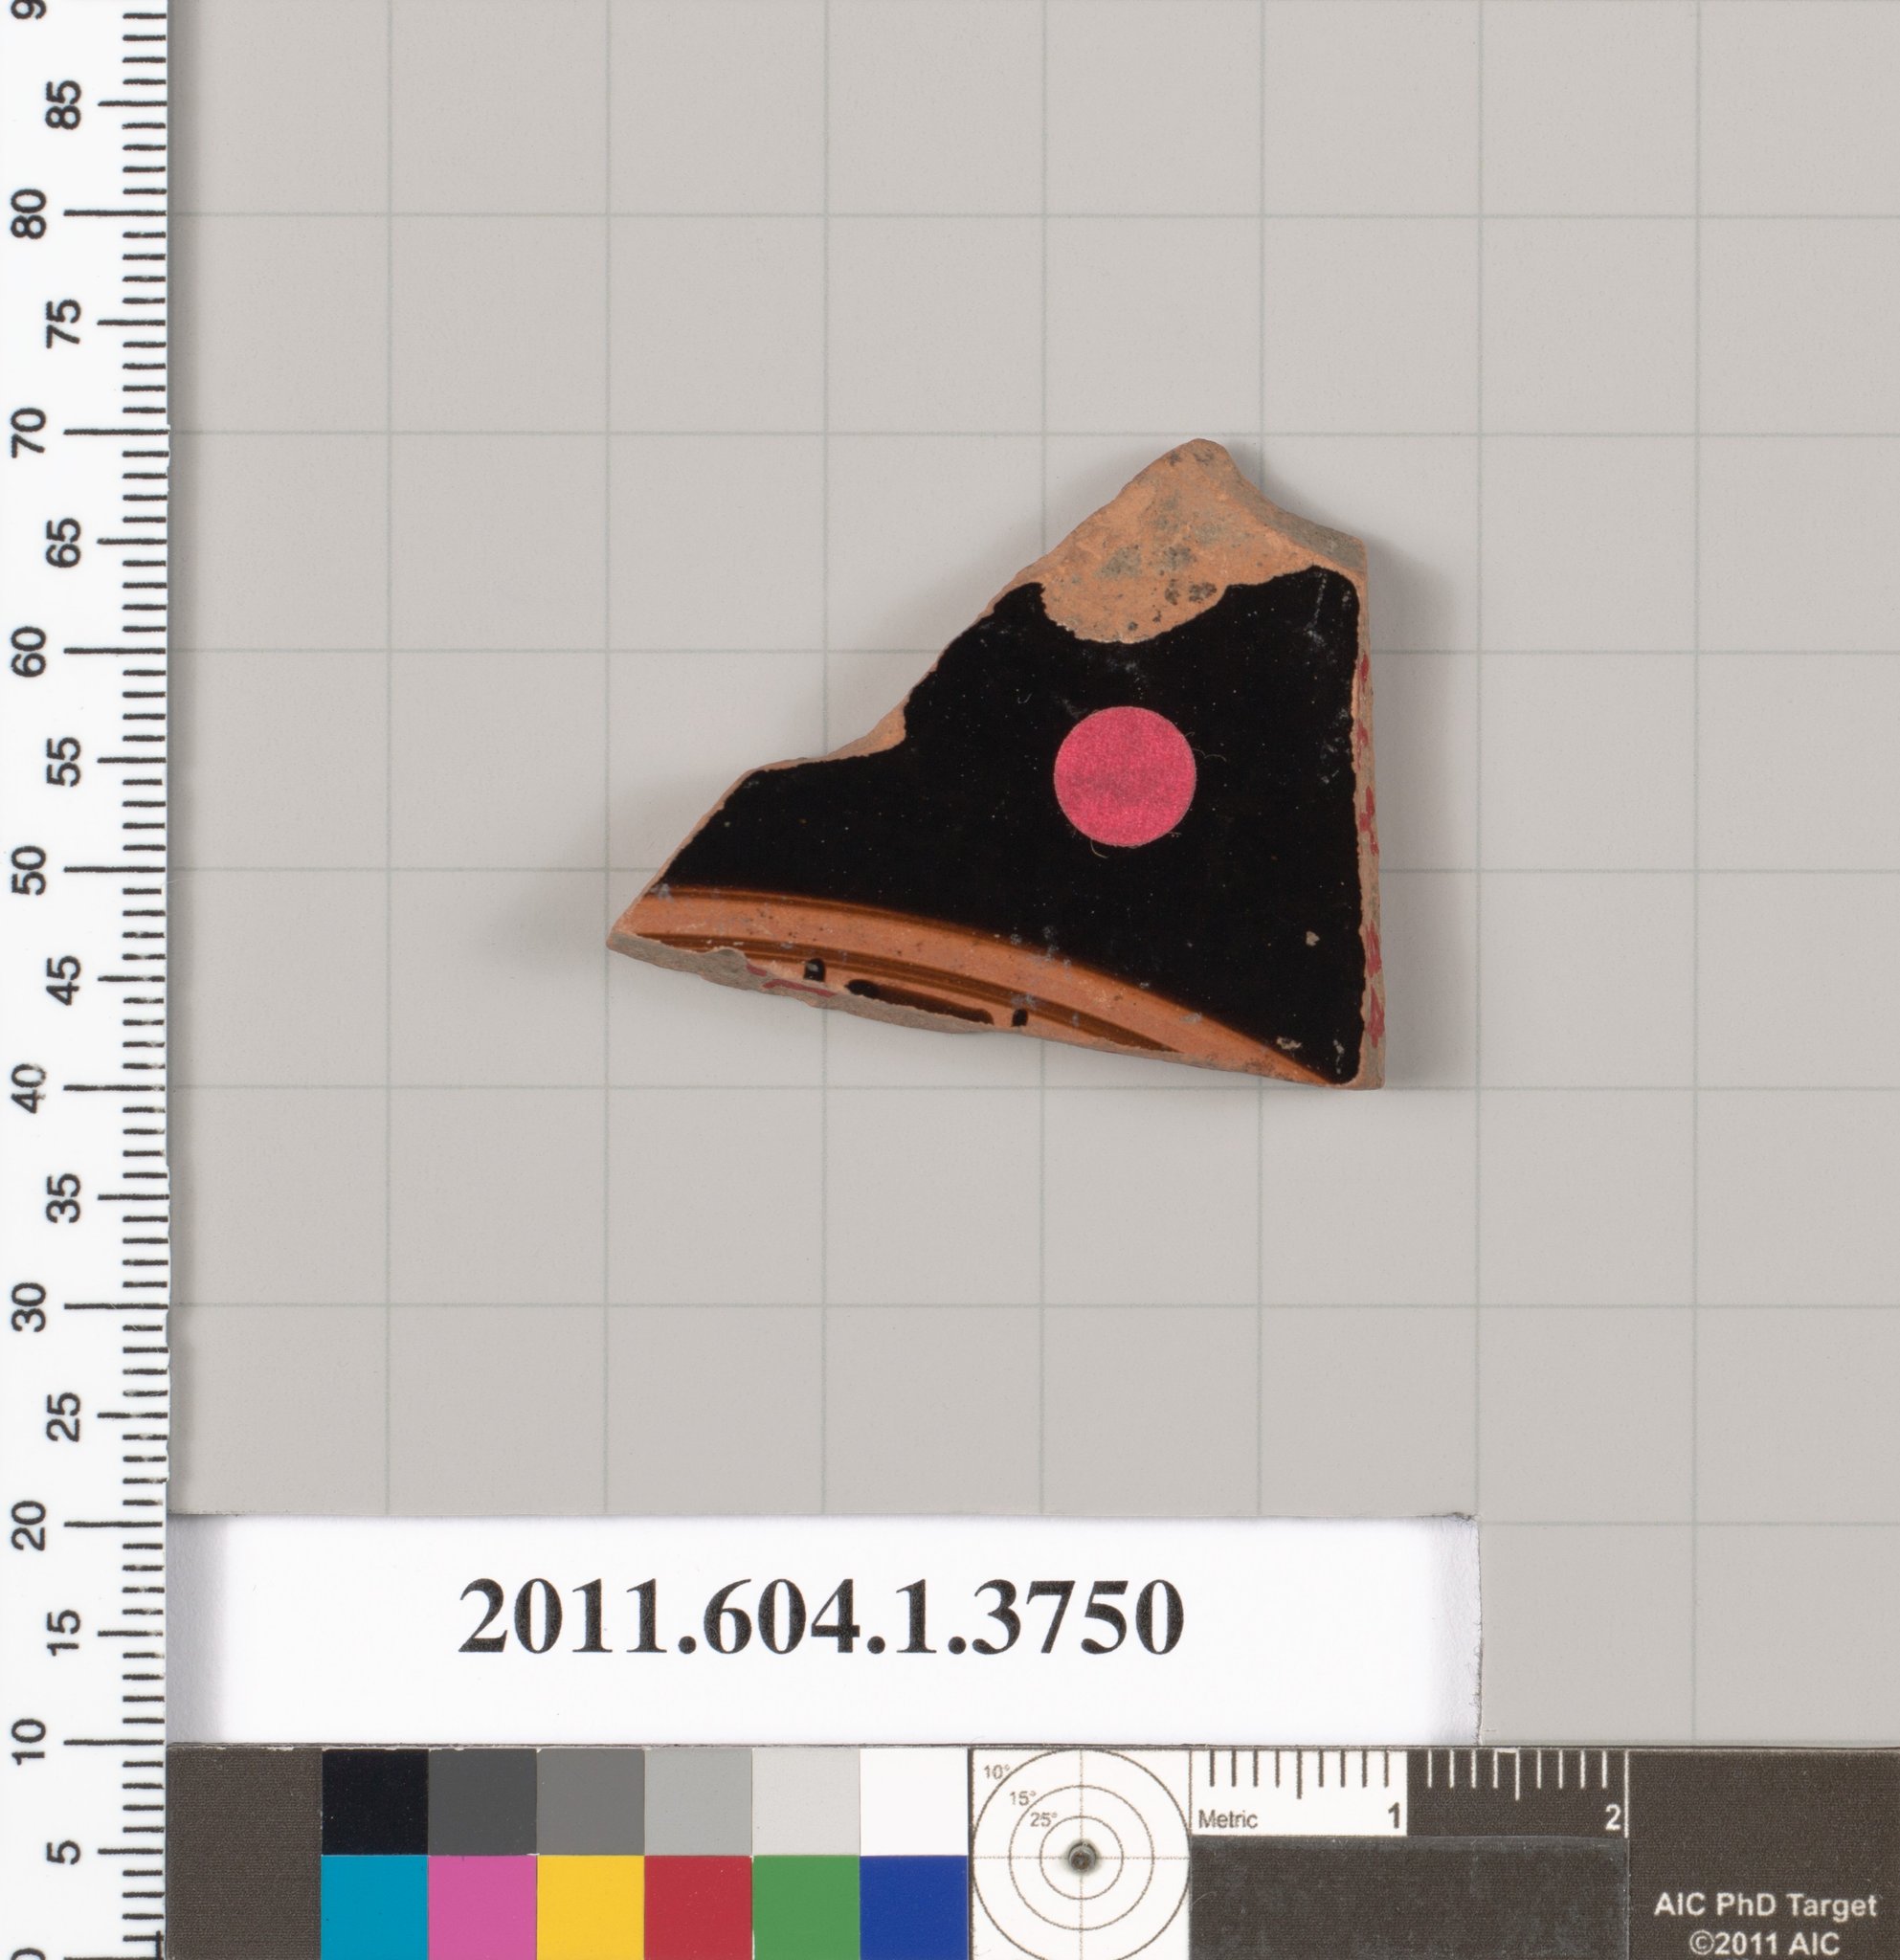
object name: kylix fragment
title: Terracotta fragment of a kylix (drinking cup)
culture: greek, attic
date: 490-470 BCE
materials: terracotta